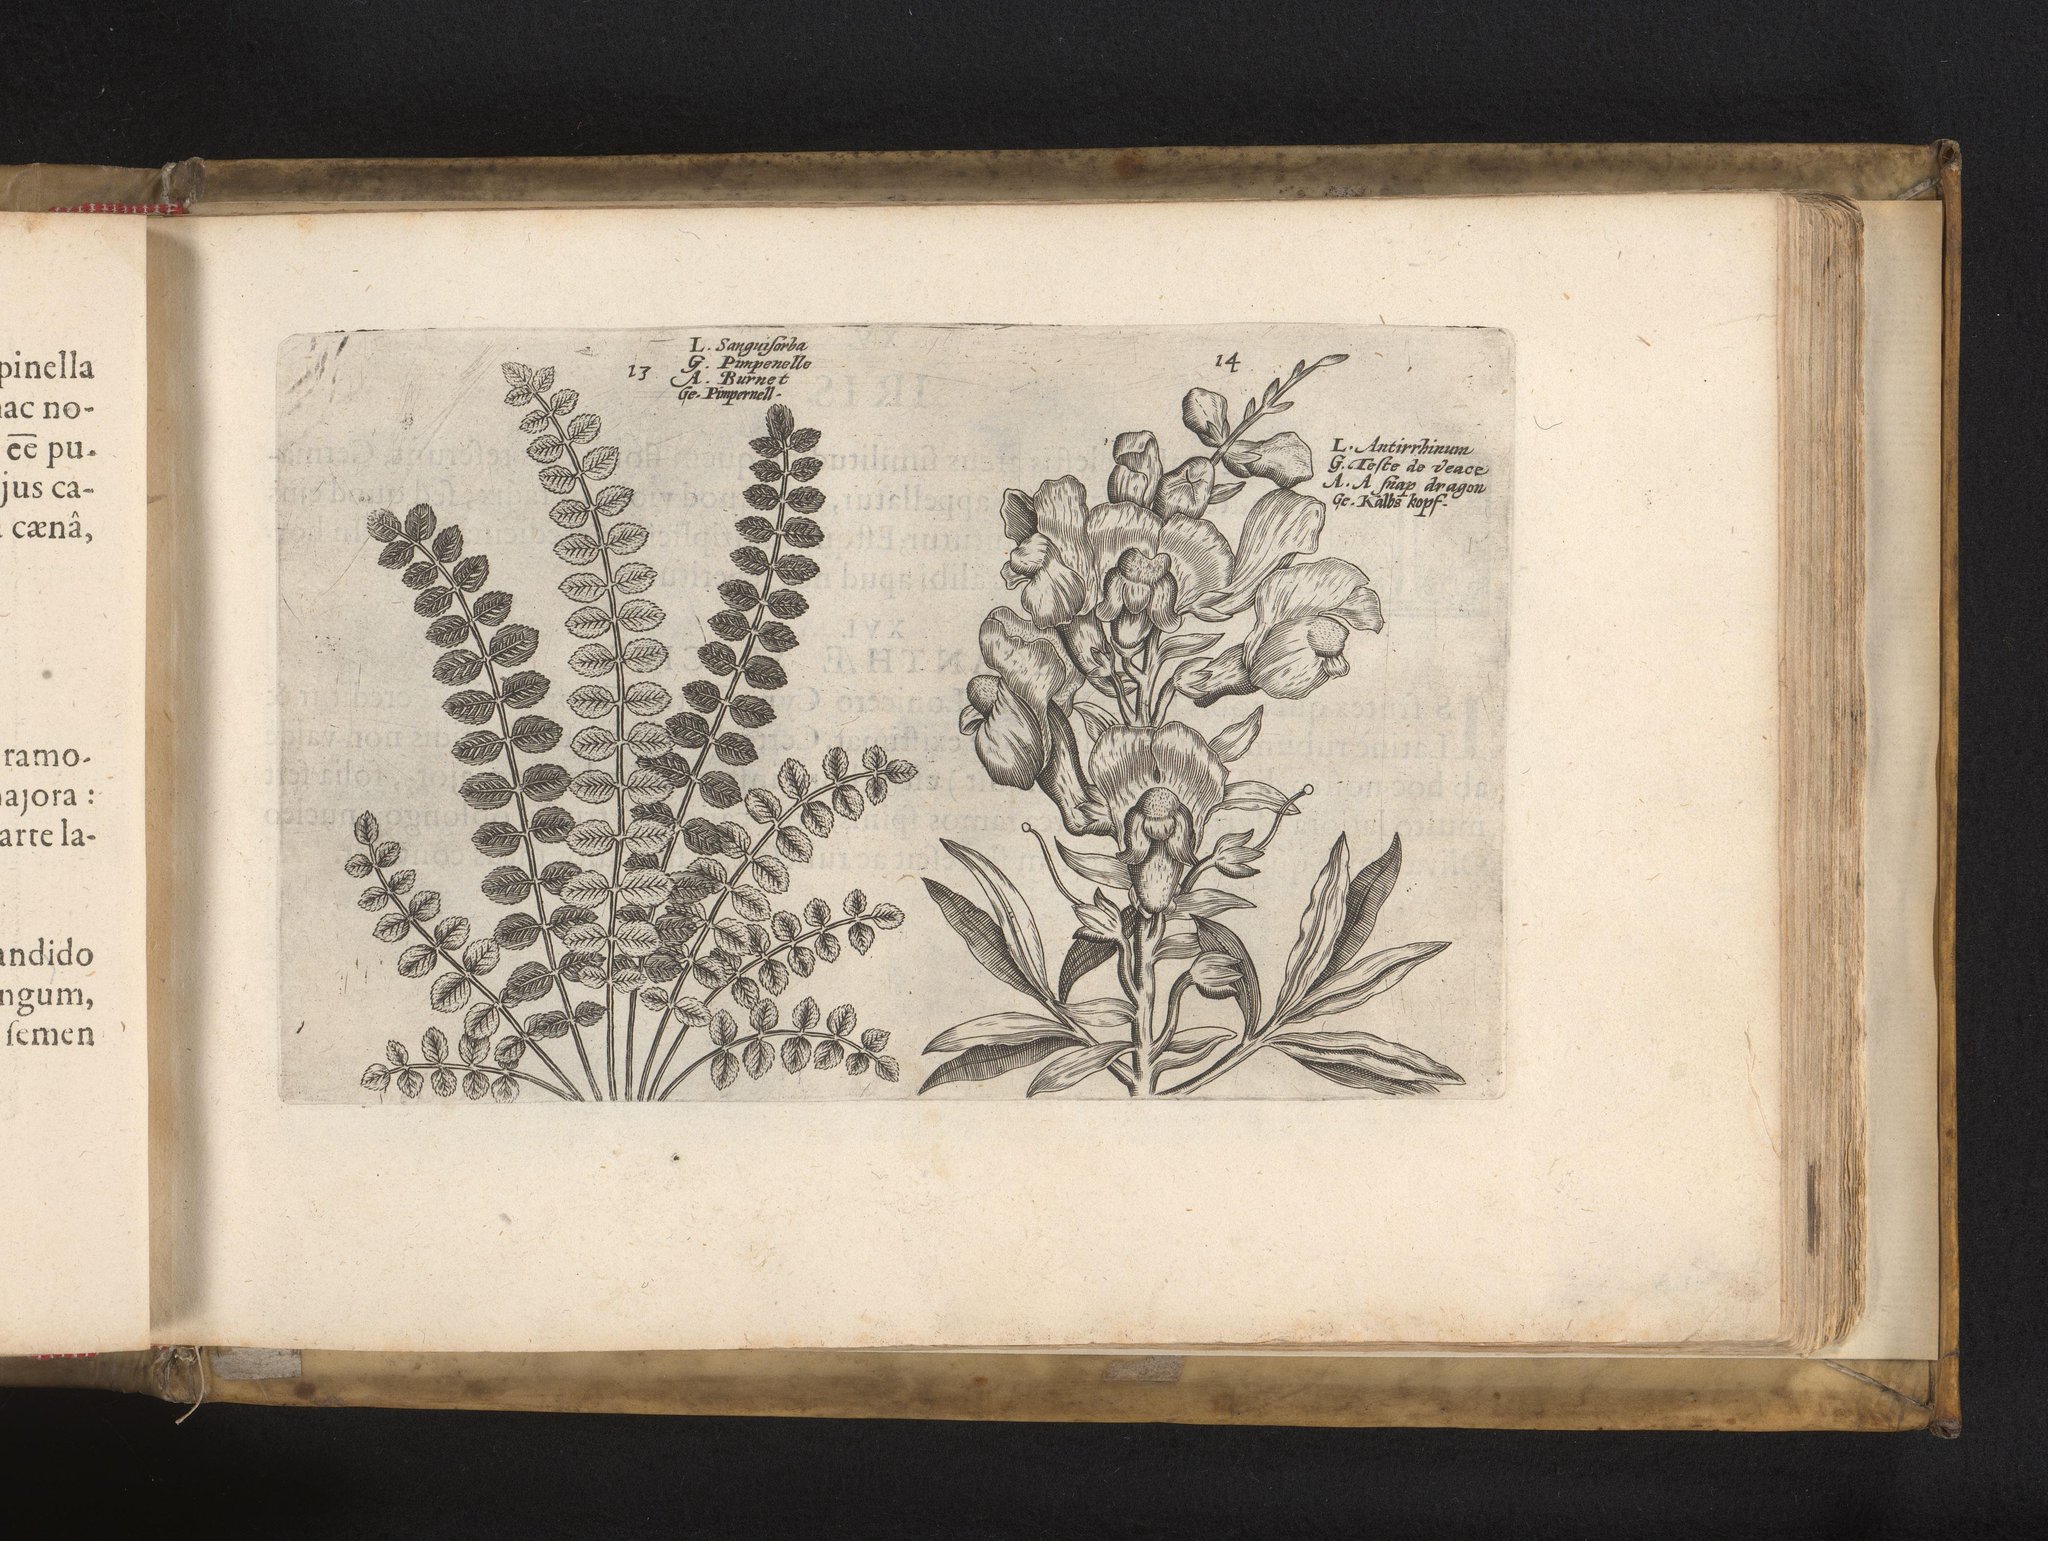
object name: book illustration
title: Antirrhunum / Teste de veace / A snap dragon / Kalbs Kopf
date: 1617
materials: paper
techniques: engraving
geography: arnhem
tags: flowers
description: Prent uit: Passe, Crispijn van de (II). Hortus floridus in quo rariorum & minus vulgarium florum icones ad vivam veramque formam. Arnhem: Johannes Janssonius, 1617.